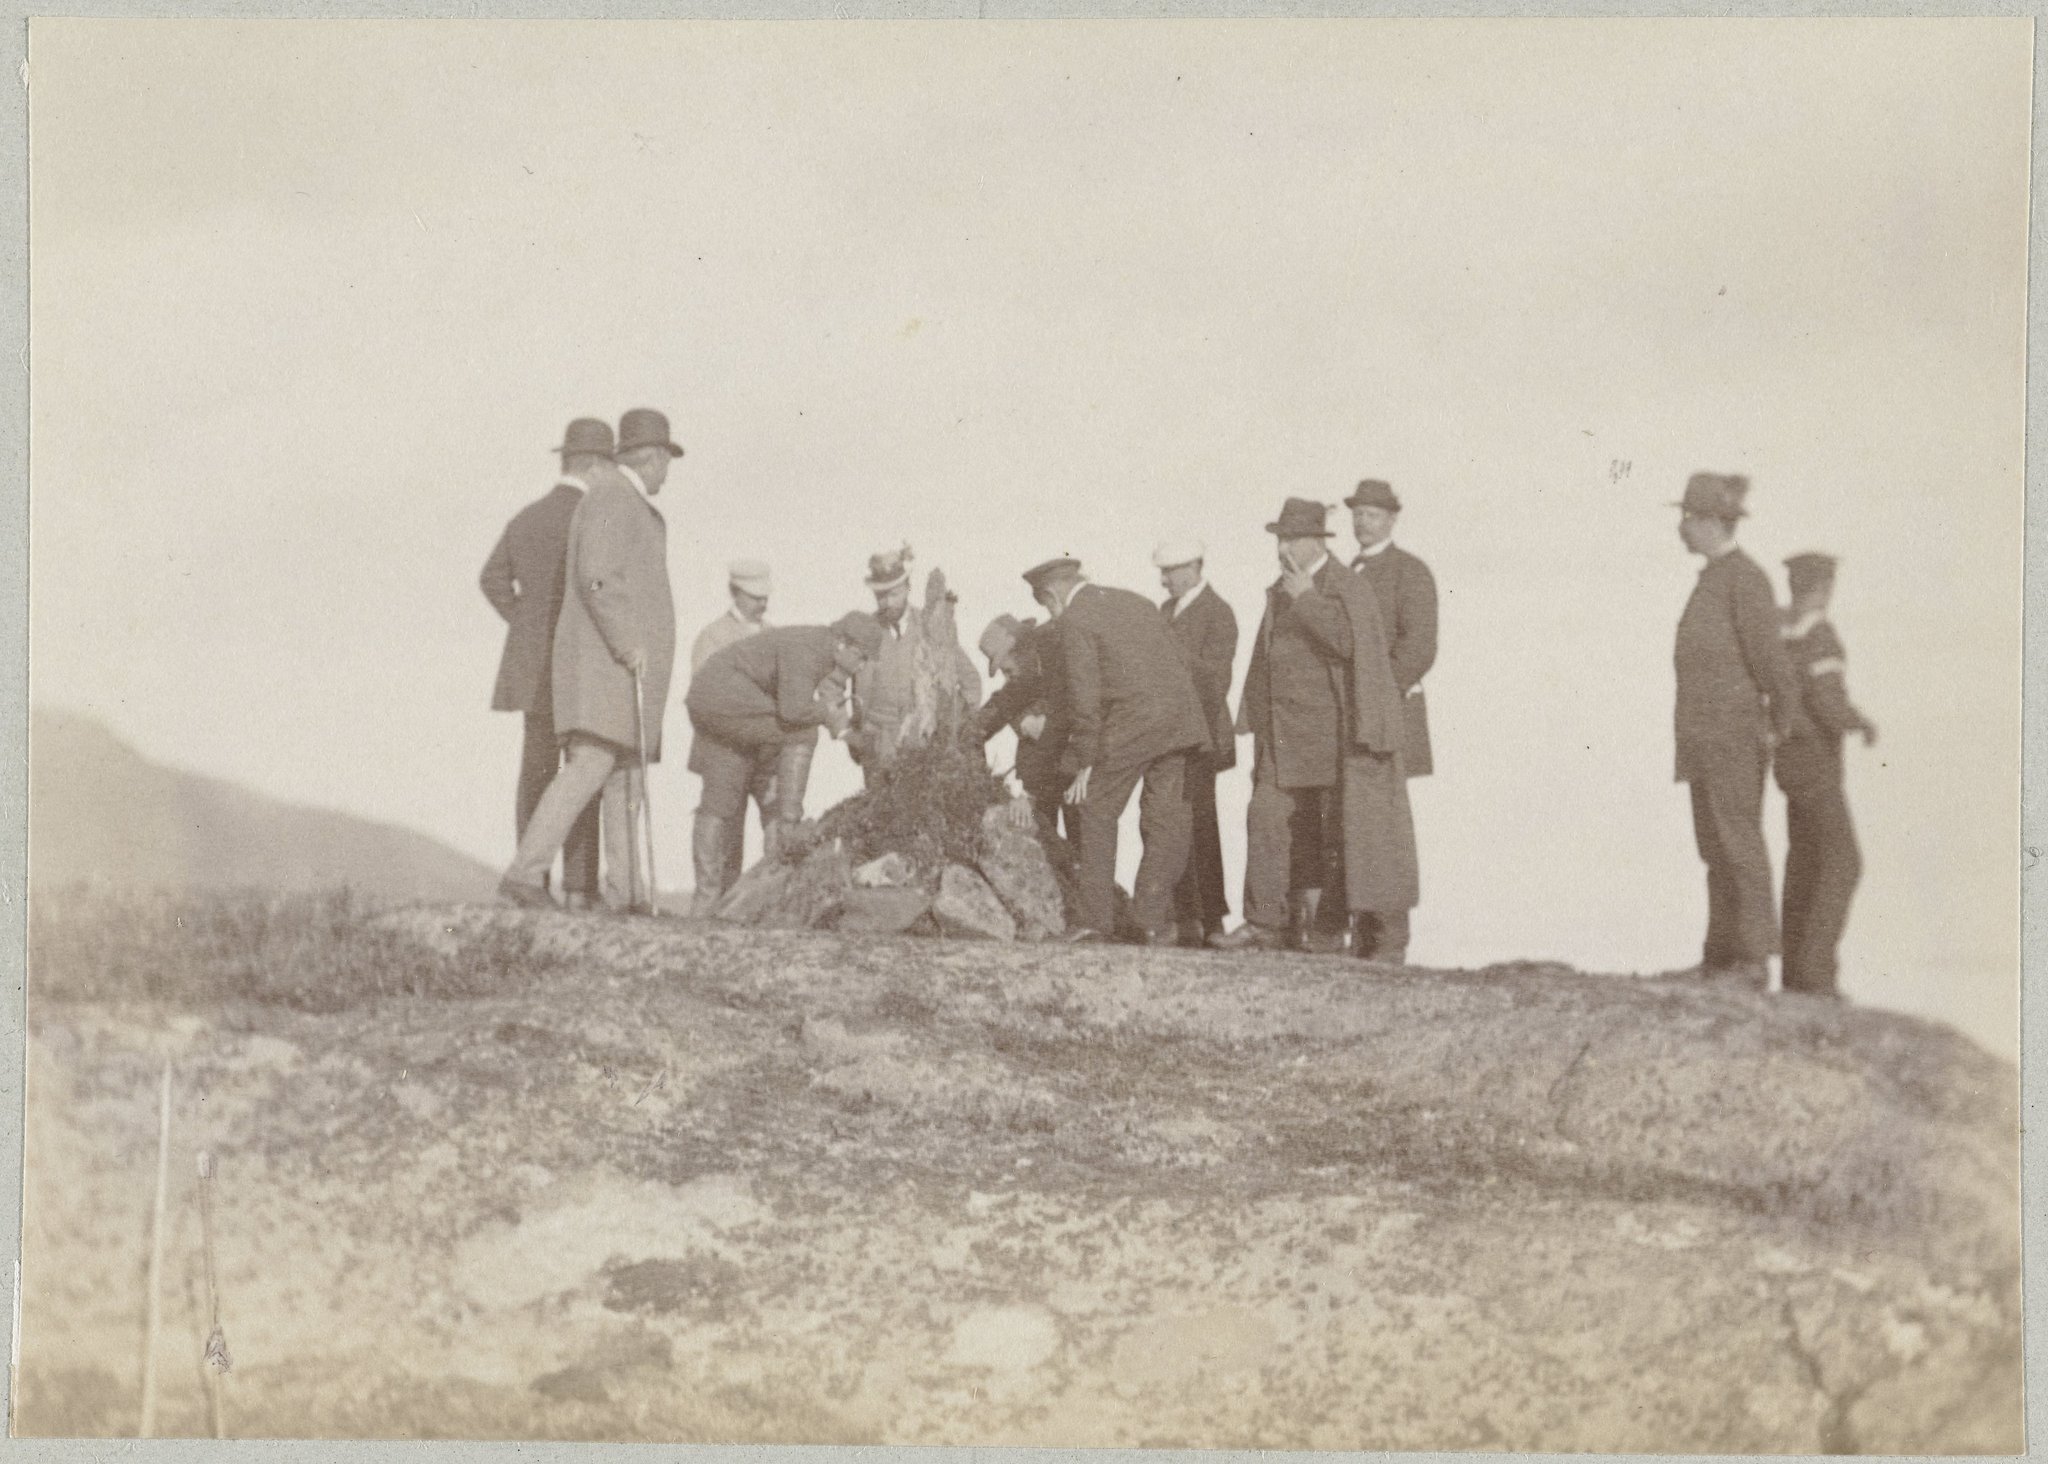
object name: photograph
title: Keizer Wilhelm II met zijn reisgezelschap in het Noorse landschap bij uitkijkpunt in Lofoten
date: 1807-1889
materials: cardboard, paper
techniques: albumen print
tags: wilhelm ii (keizer van duitsland), norway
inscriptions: number: ‘33’